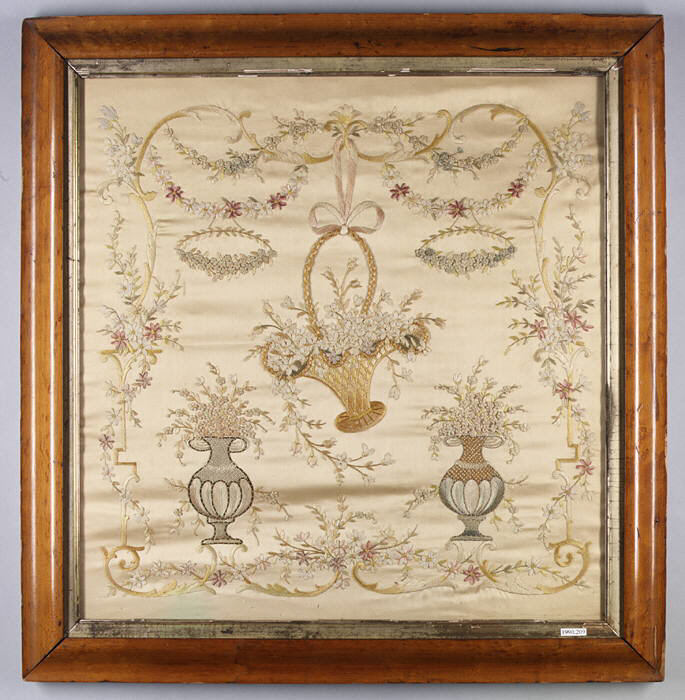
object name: panel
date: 1867-1900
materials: metal thread, ribbon, silk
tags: garlands,flowers